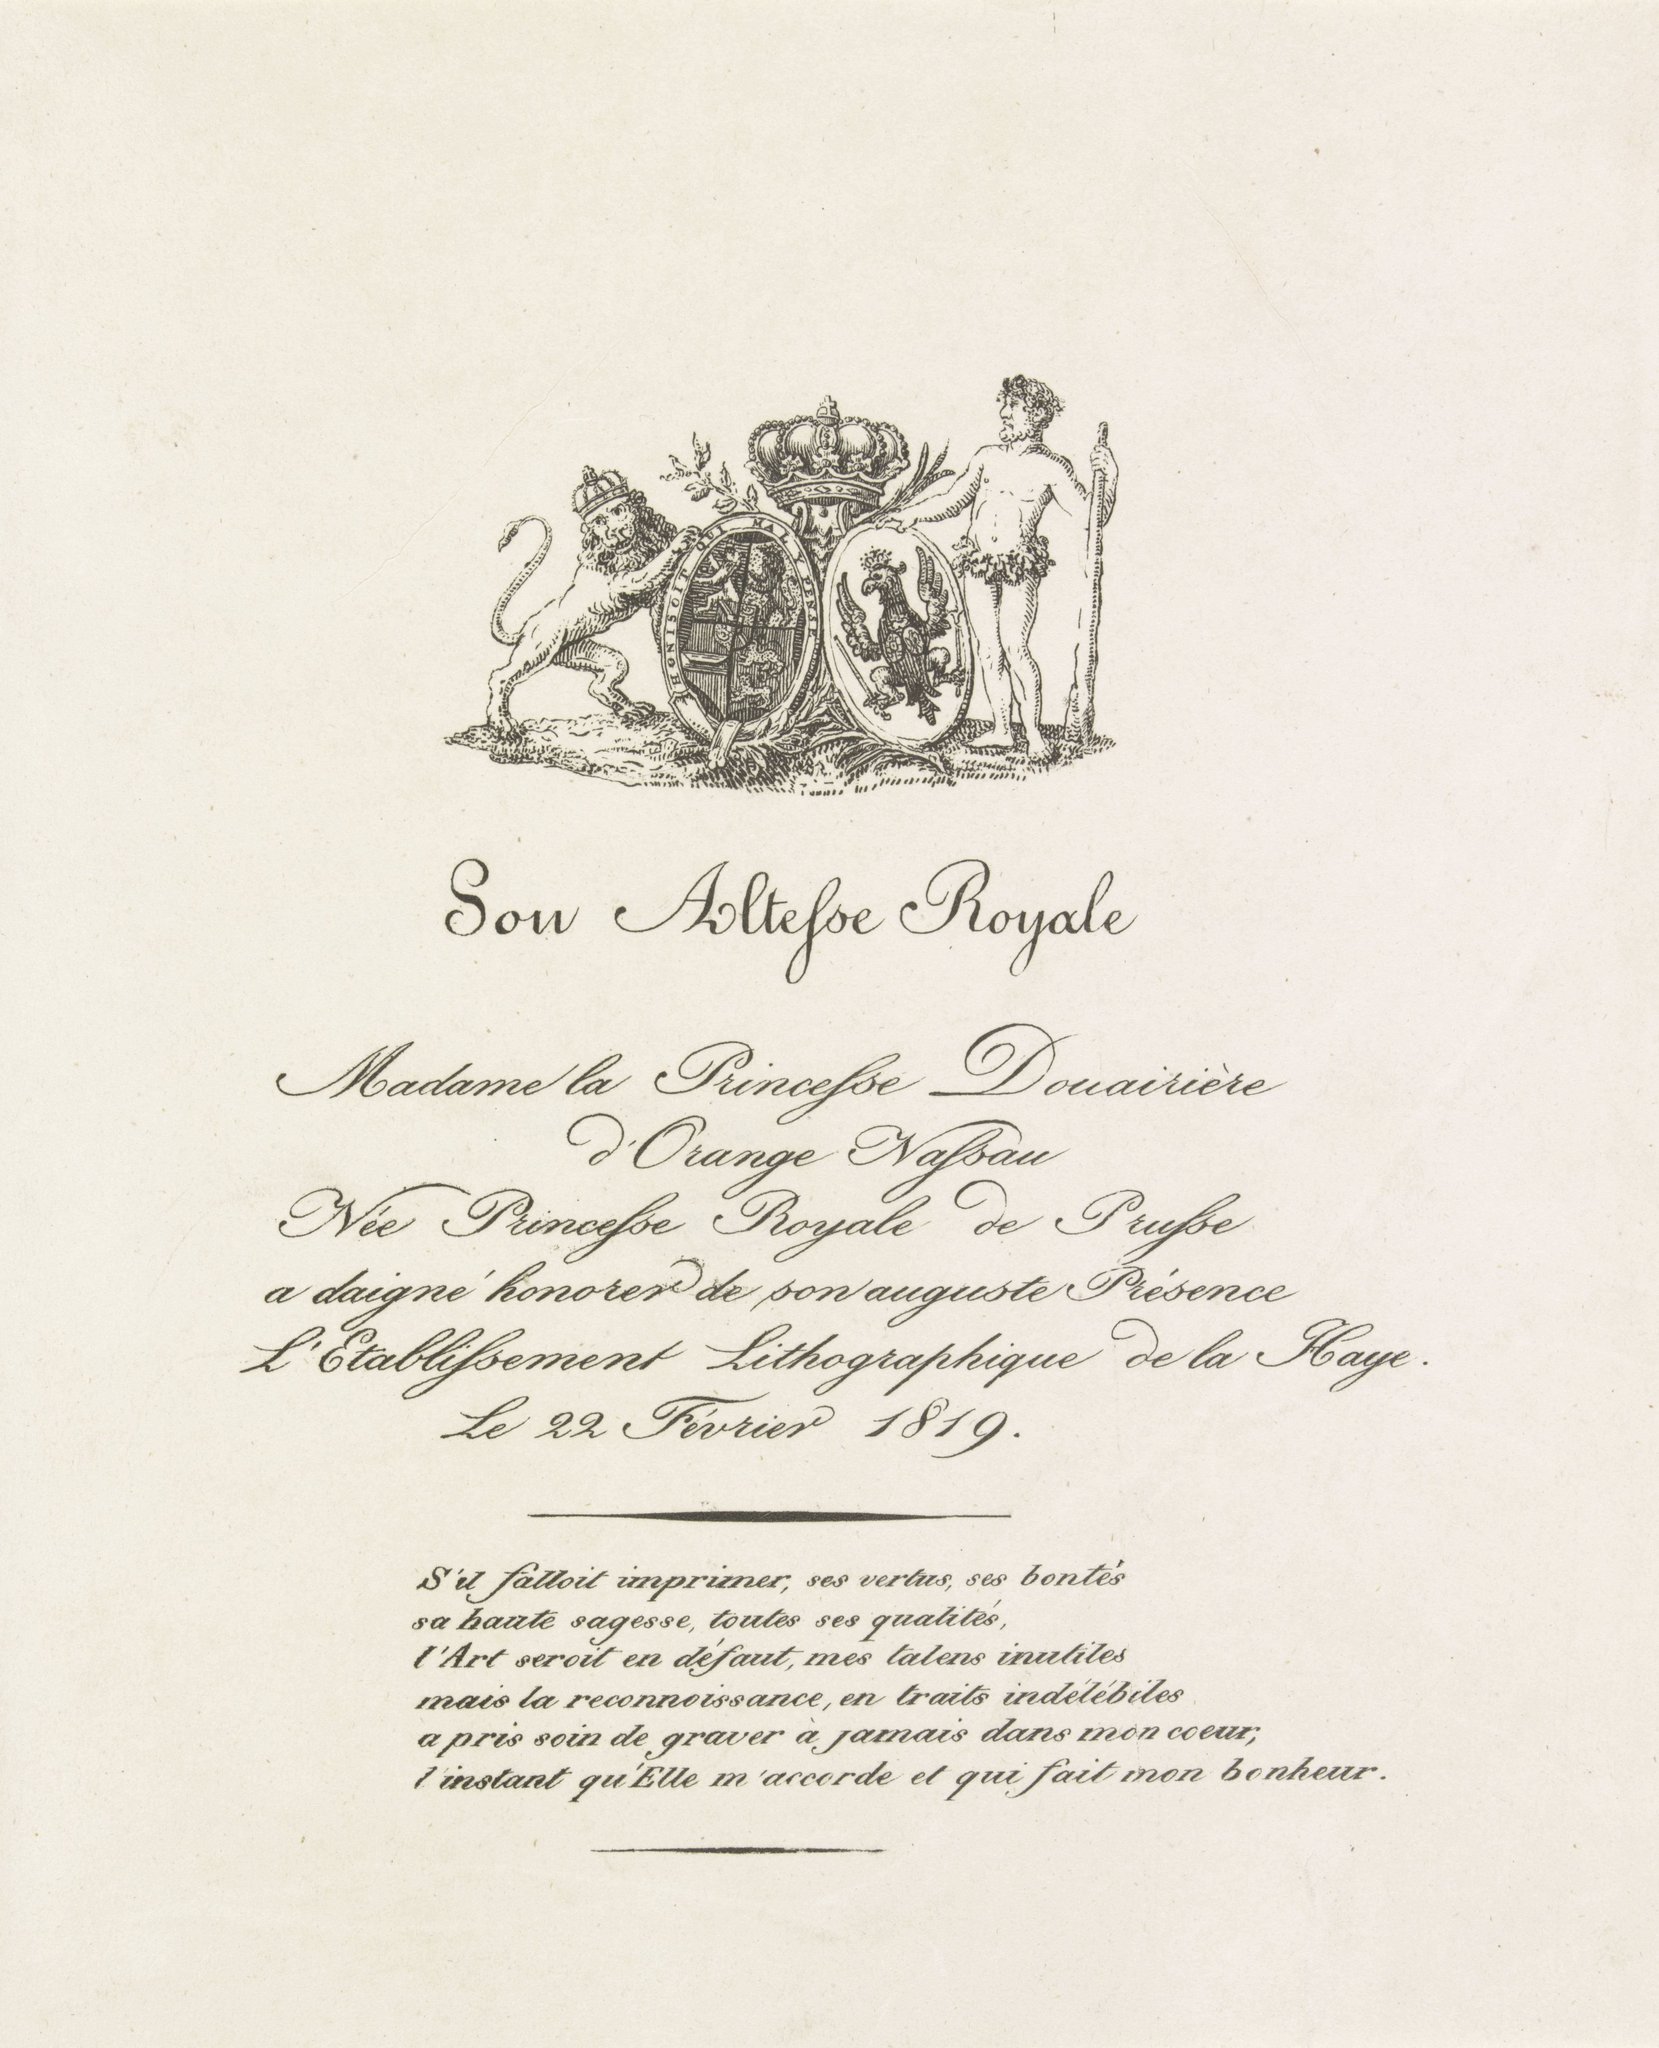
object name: print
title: Biljet van het bezoek van de prinses weduwe van Oranje Nassau aan een lithografisch atelier te 's-Gravenhage, 22 februari 1819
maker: Anonymous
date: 1802-1819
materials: paper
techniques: lithograph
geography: the hague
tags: berlin, painter, draughtsman, wilhelmina of prussia (princess of orange), the hague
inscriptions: collector's mark: Lugt 2228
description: Blad vervaardigd naar aanleiding van het bezoek van Wilhelmina van Pruisen, de prinses-douairière van Oranje, aan een lithografisch atelier te 's-Gravenhage op 22 februari 1819. Vignet met de wapens van Nederland en Pruisen, daaronder de tekst over het bezoek gevolgd door een zesregelig vers in het Frans.